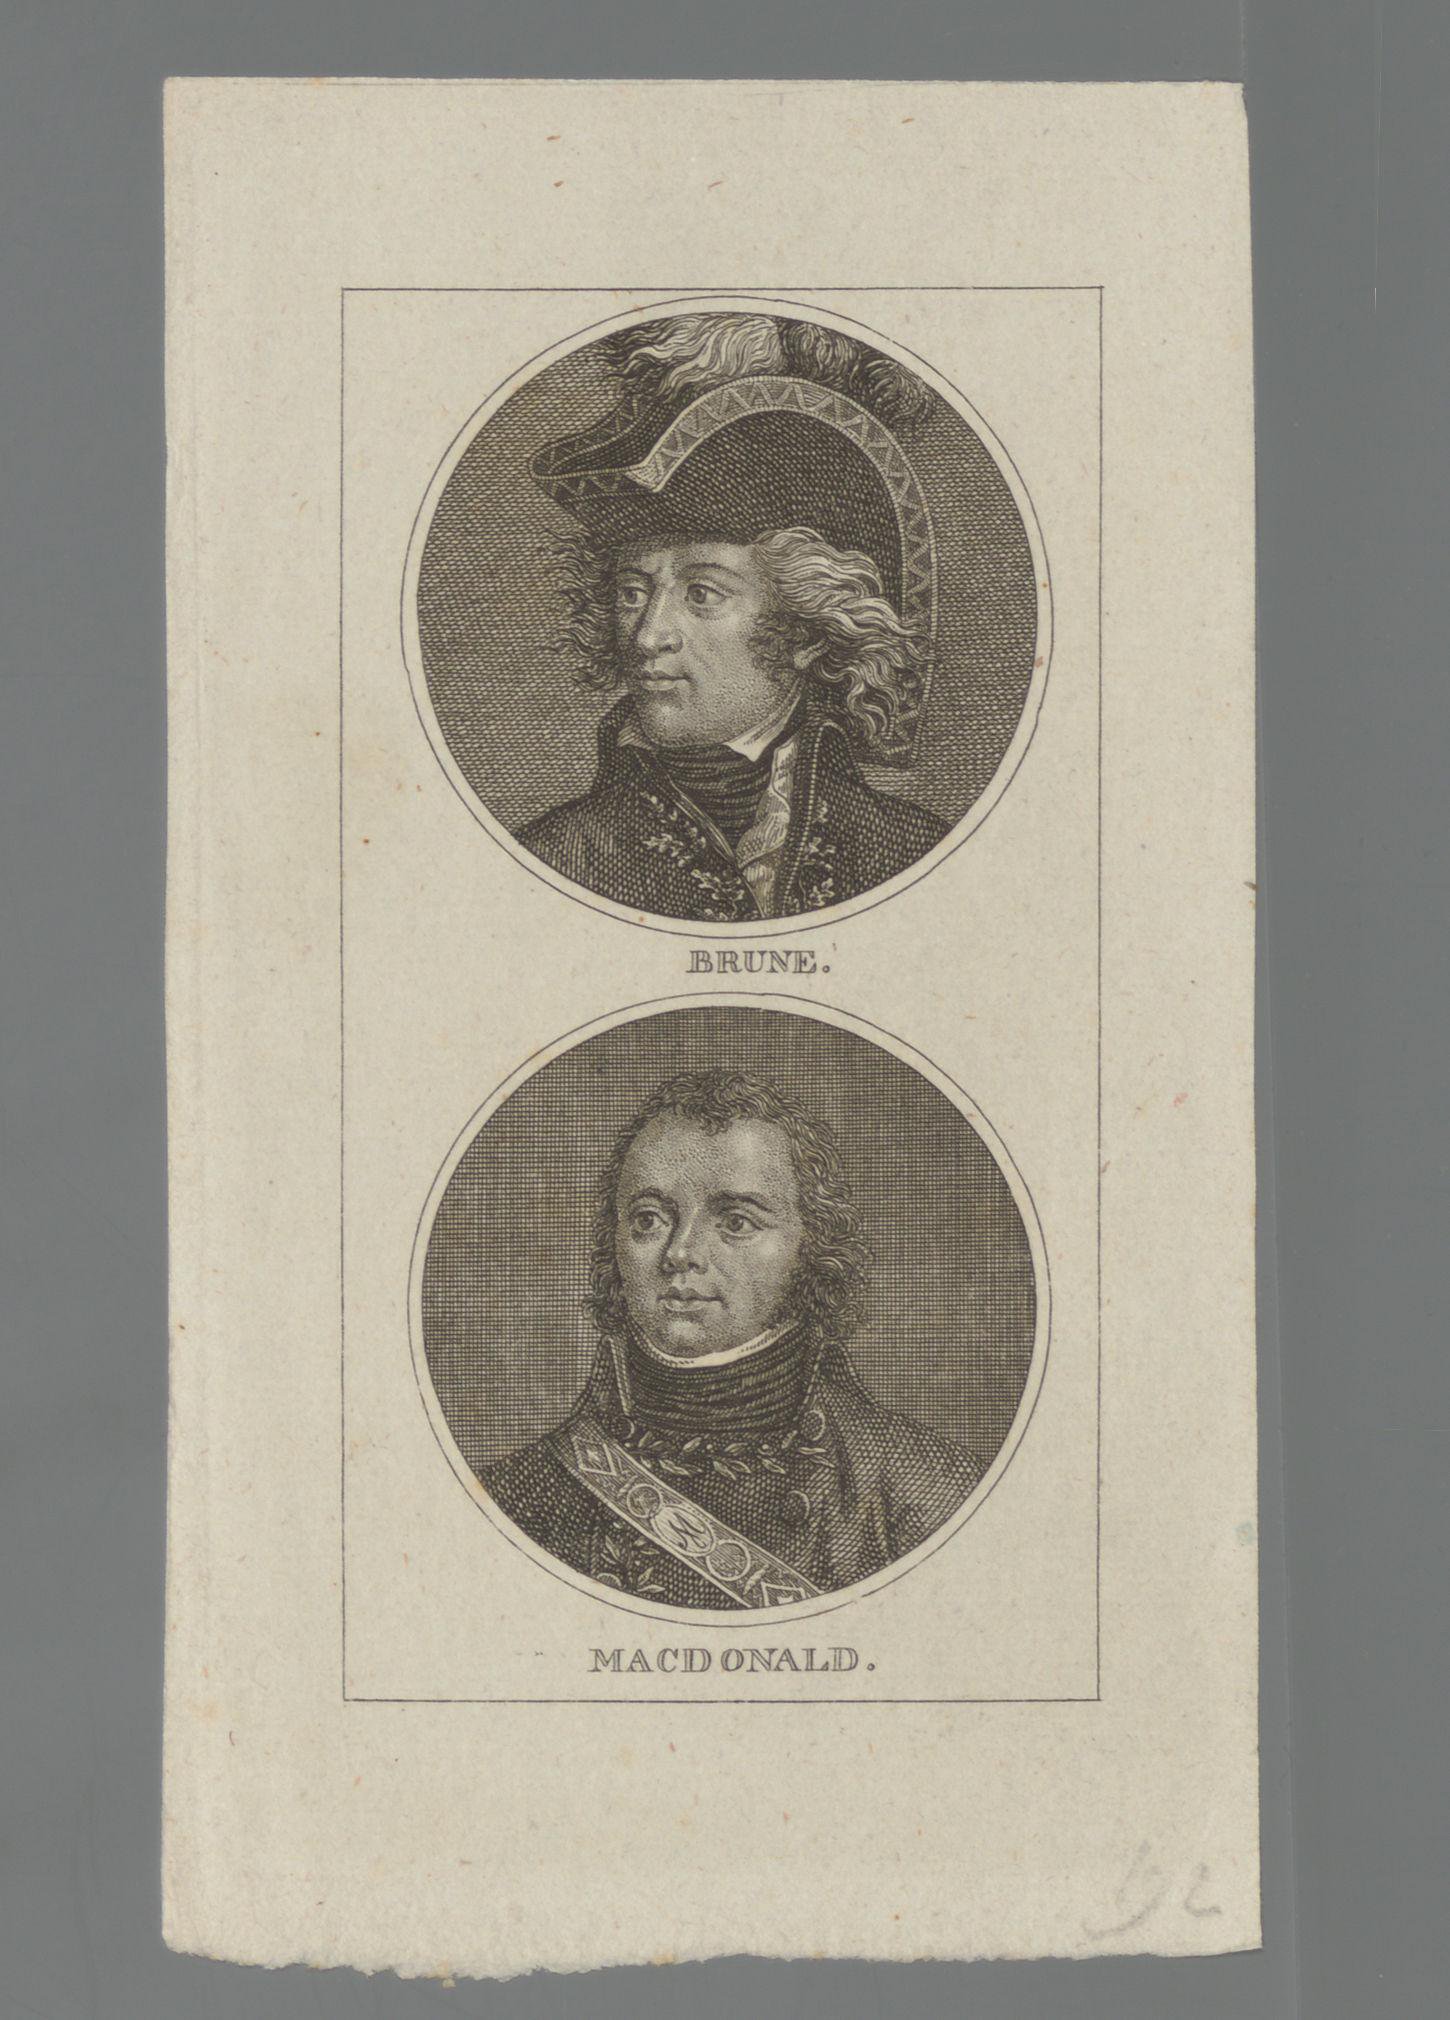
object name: print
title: Portretten van Guillaume-Marie-Anne Brune en Étienne Jacques Joseph Macdonald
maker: Anonymous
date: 1799-1899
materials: paper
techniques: etching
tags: commander-in-chief, general, marshal, historical persons